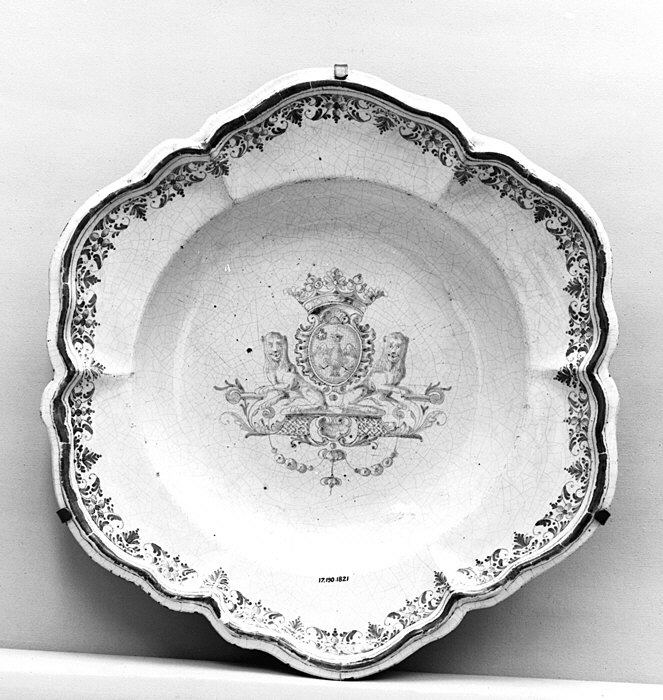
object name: platter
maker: jacques hustin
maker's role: maker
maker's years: 1649-1749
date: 1701-1733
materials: faience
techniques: glazing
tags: coat of arms